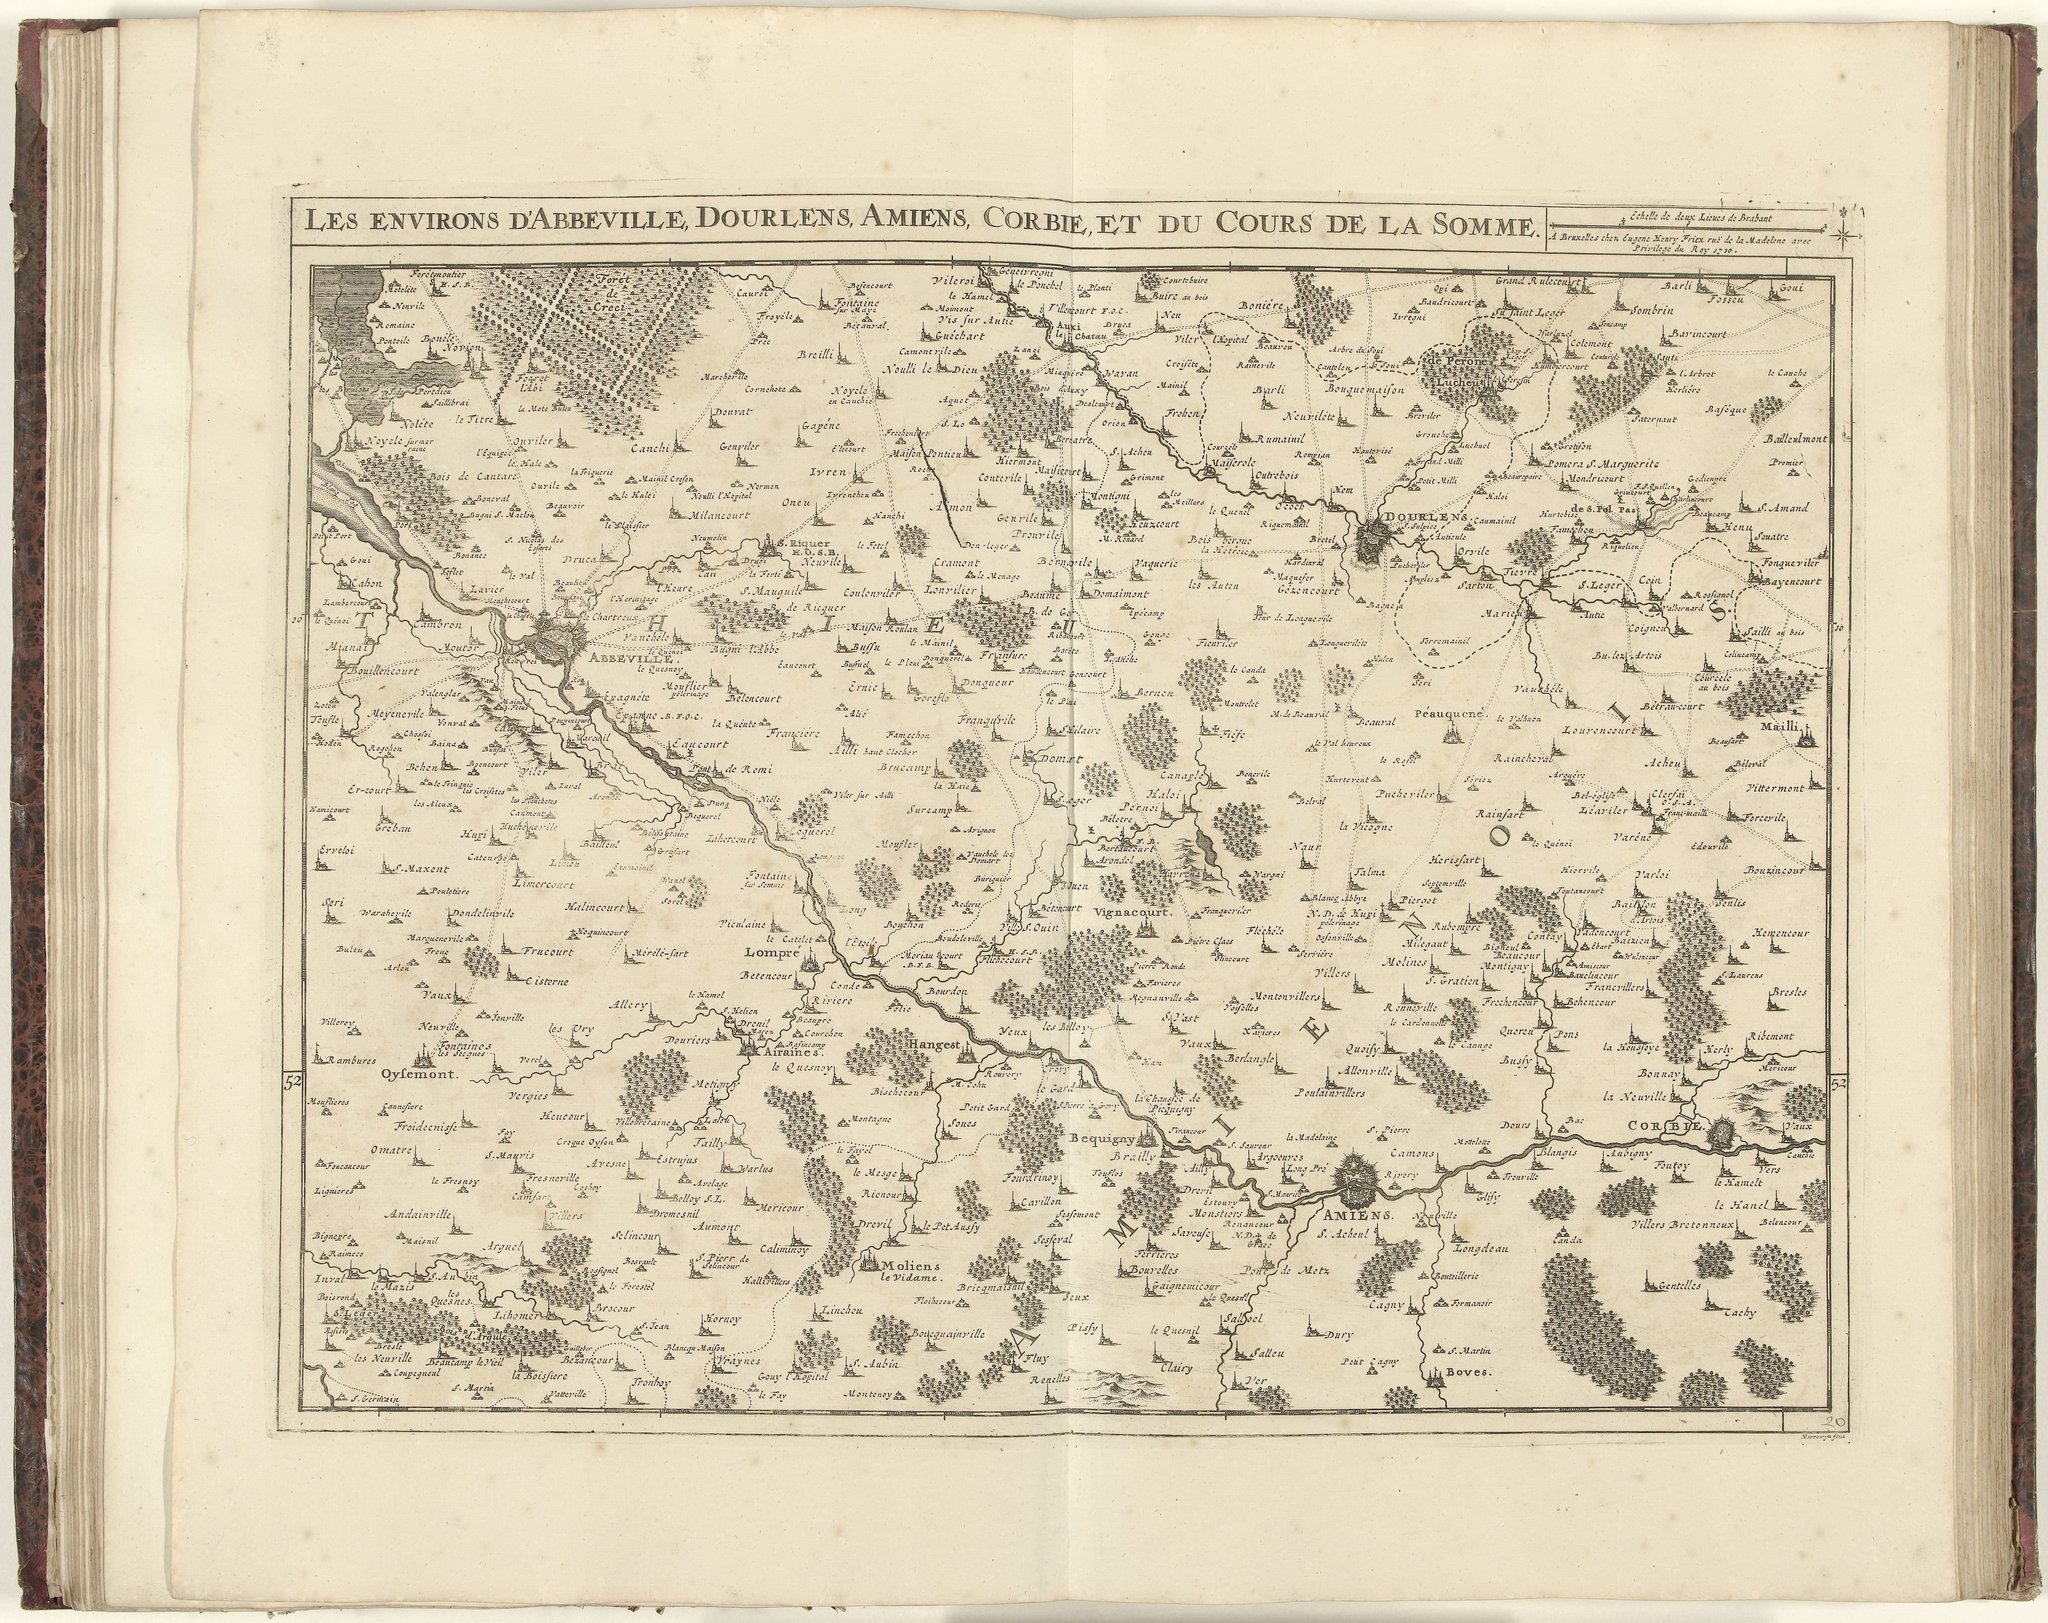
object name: print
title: Les environs d'Abbeville, Dourlens, Amiens, Corbie, et du cours de la Somme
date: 1710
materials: paper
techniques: engraving, etching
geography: brussels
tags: maps of separate countries or regions, northern france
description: Kaart van Noord-Frankrijk met het gebied rond de loop van de rivier de Somme, 1710. Onderdeel van een gebundelde verzameling van plannen van veldslagen en steden vermaard in de Spaanse Successieoorlog. Deze plaat behoort tot de eerste 24 platen die samen een zeer grote kaart van de Zuidelijke Nederlanden vormen.